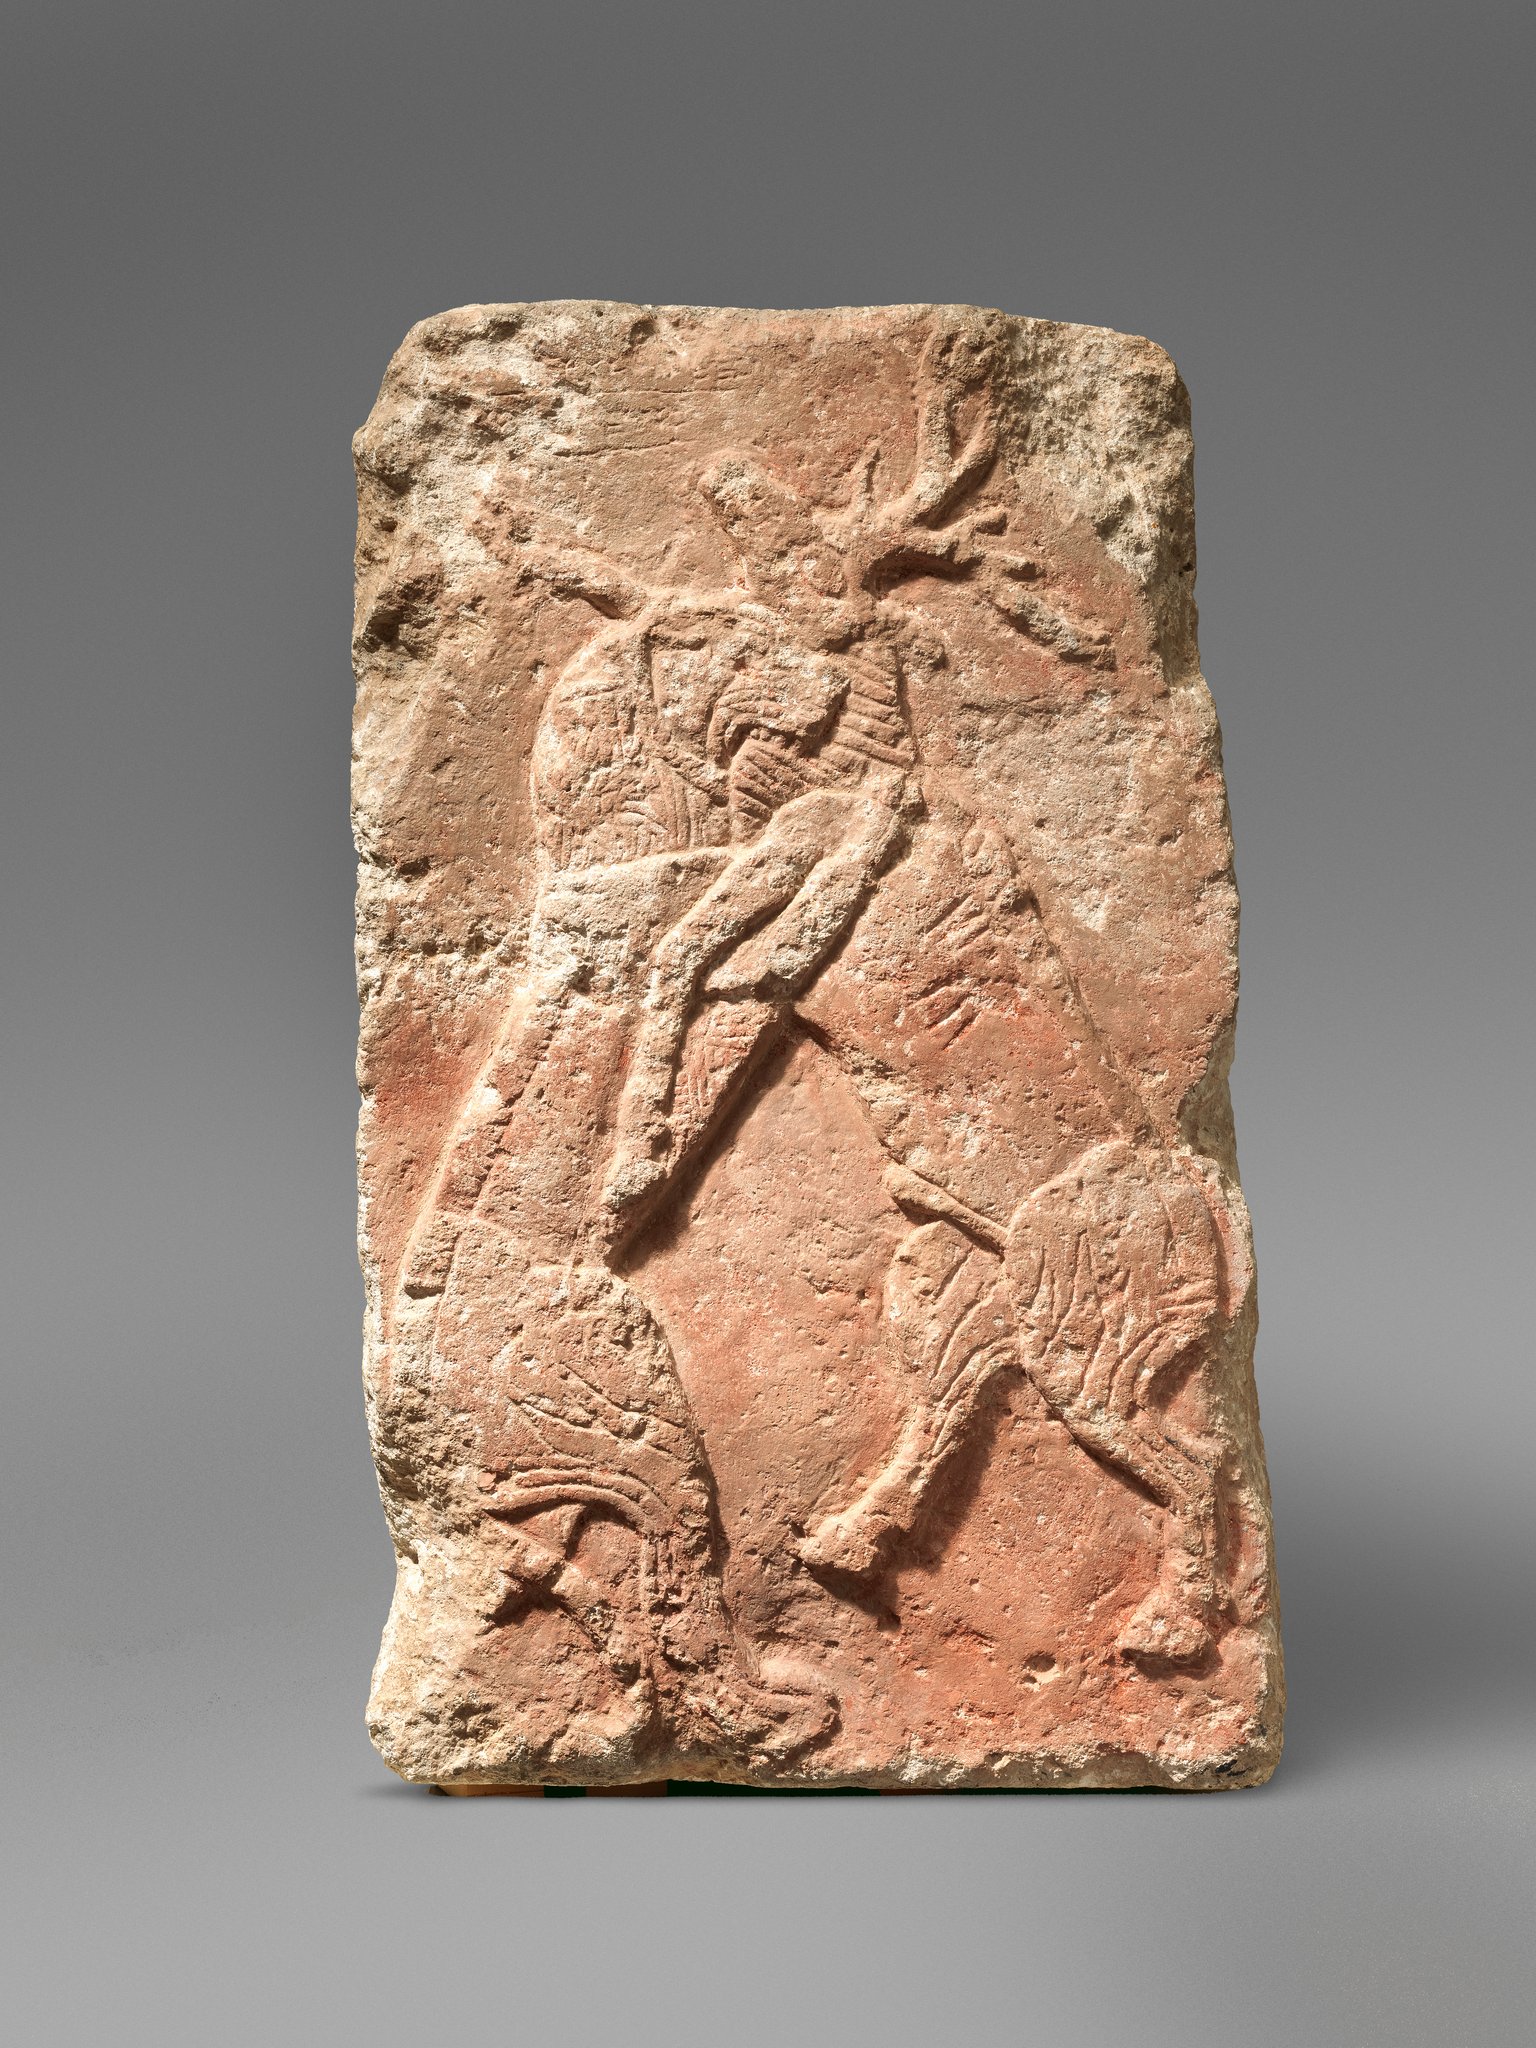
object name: relief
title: Orthostat relief: lion attacking a deer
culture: hittite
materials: limestone, paint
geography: syria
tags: deer,lions